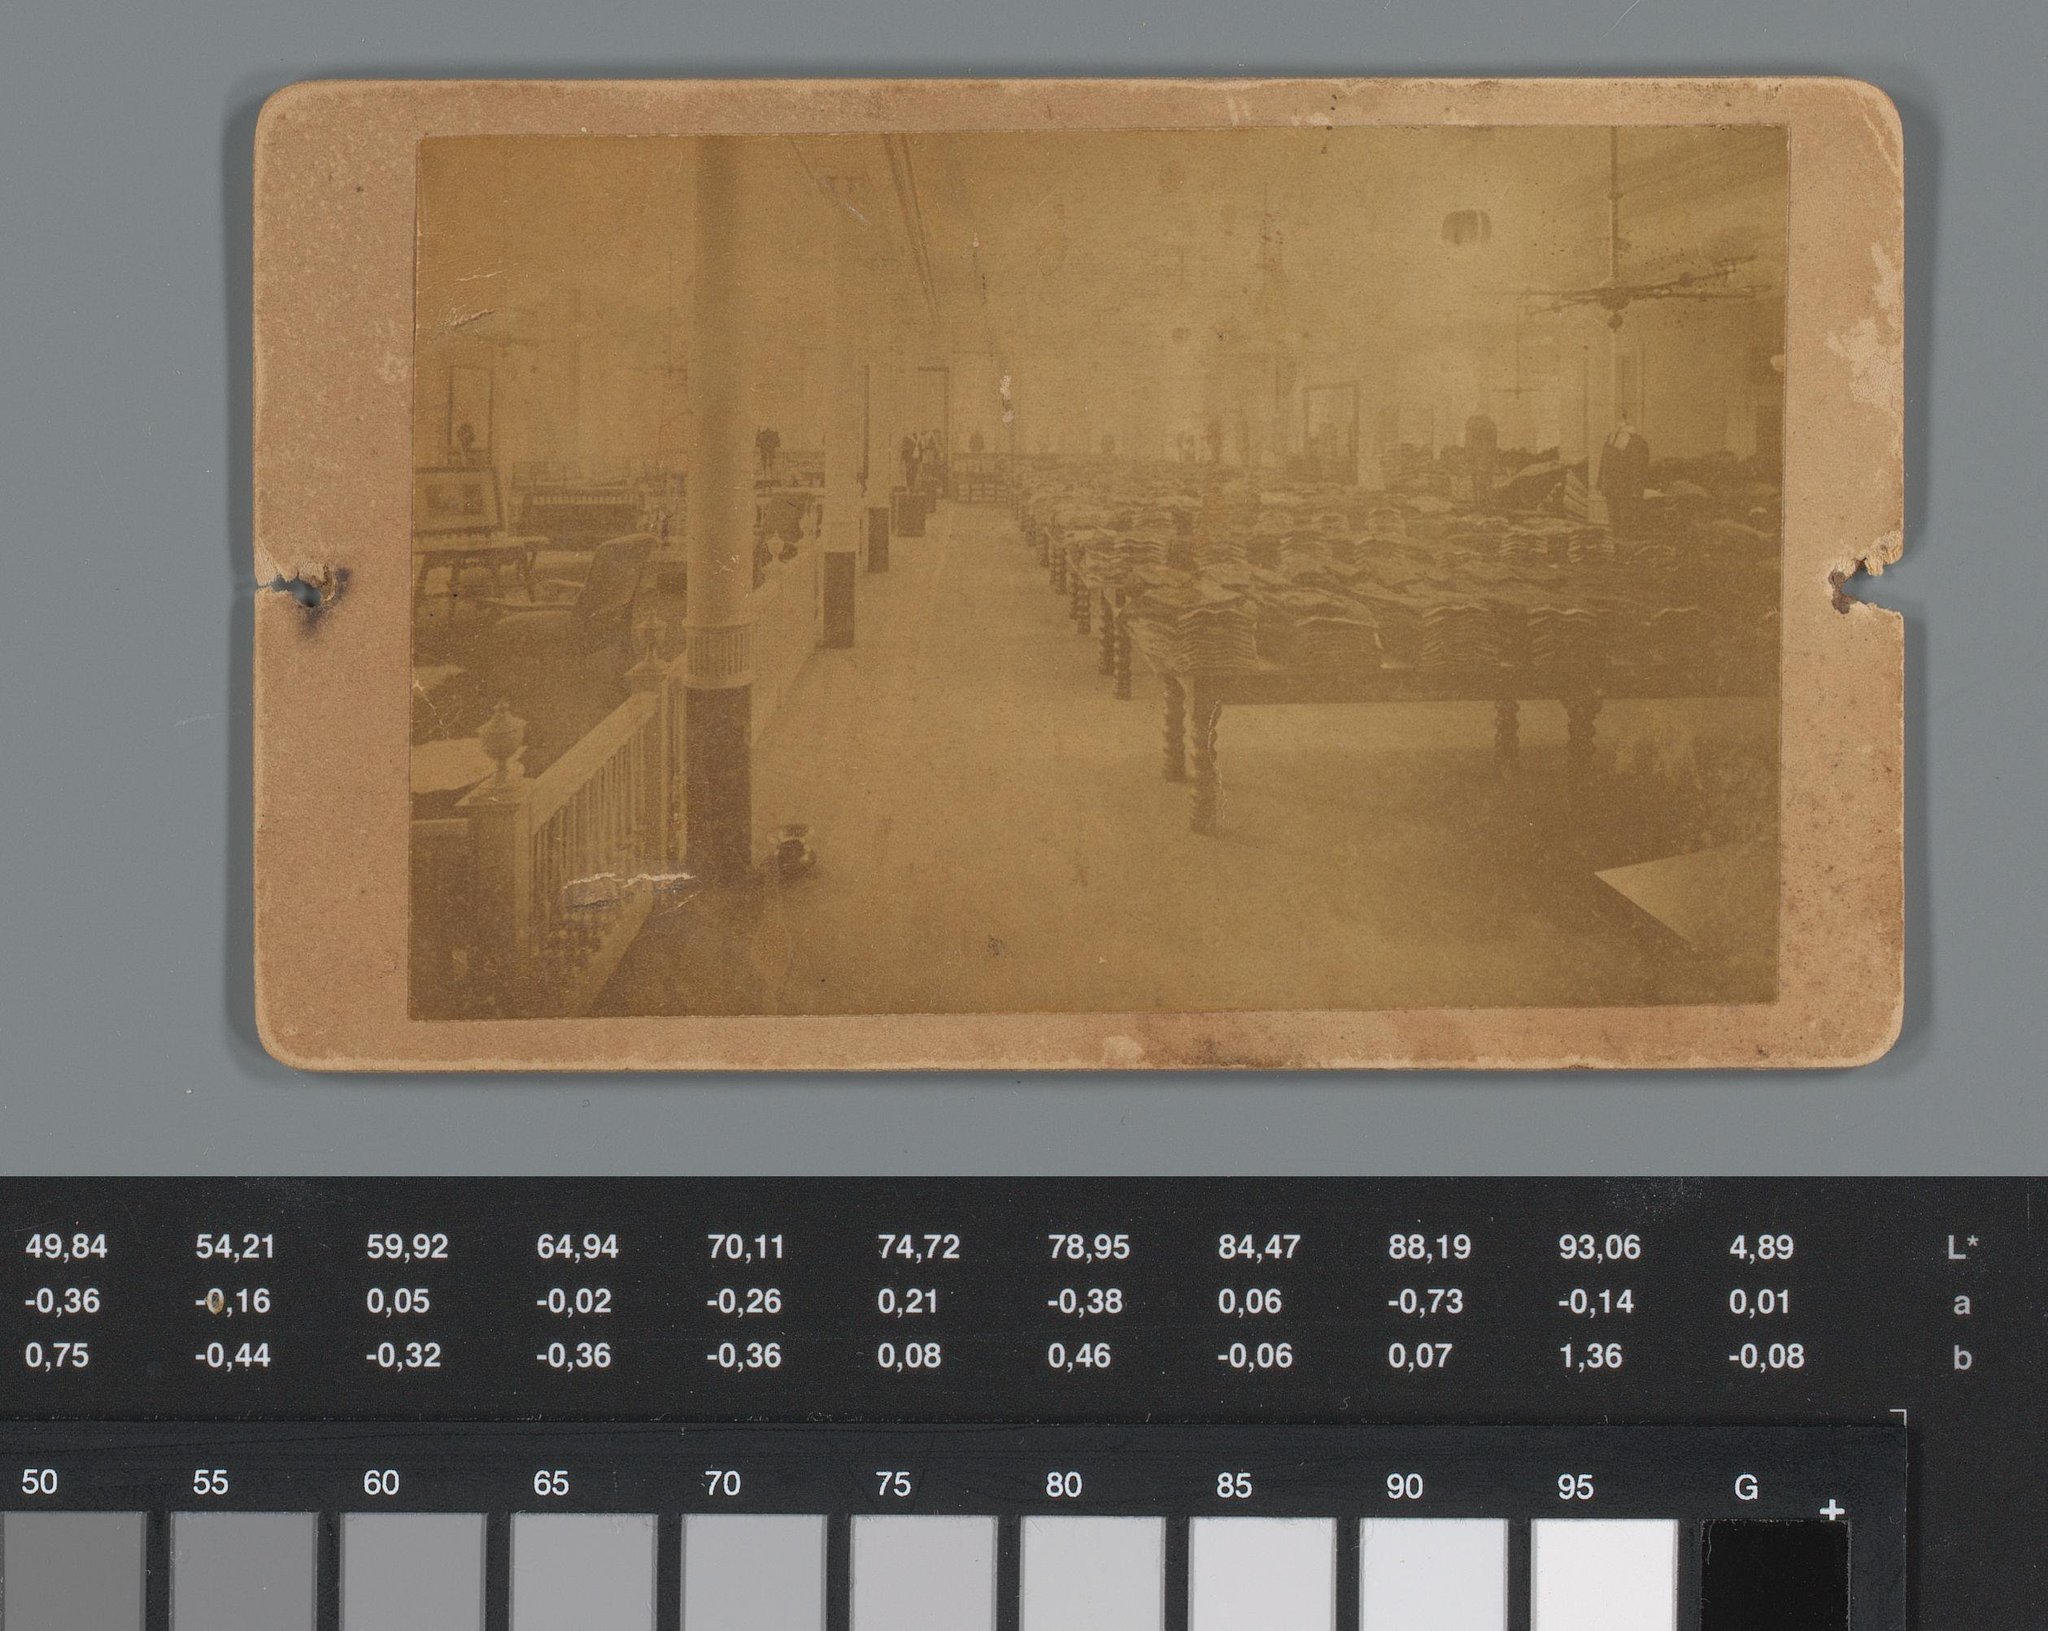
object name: photograph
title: Reclame voor kinderkleding van Browning King Co. met gezicht op het warenhuis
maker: Anonymous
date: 1850-1915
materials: cardboard, photographic support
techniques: albumen print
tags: fashion, clothing, edifice, e.g.: public building, department store - aa - civic architecture: inside, advertising, department store, supermarket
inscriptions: inscription: ‘Children's Department (...) Browning, King Co. (...) Kneeland’